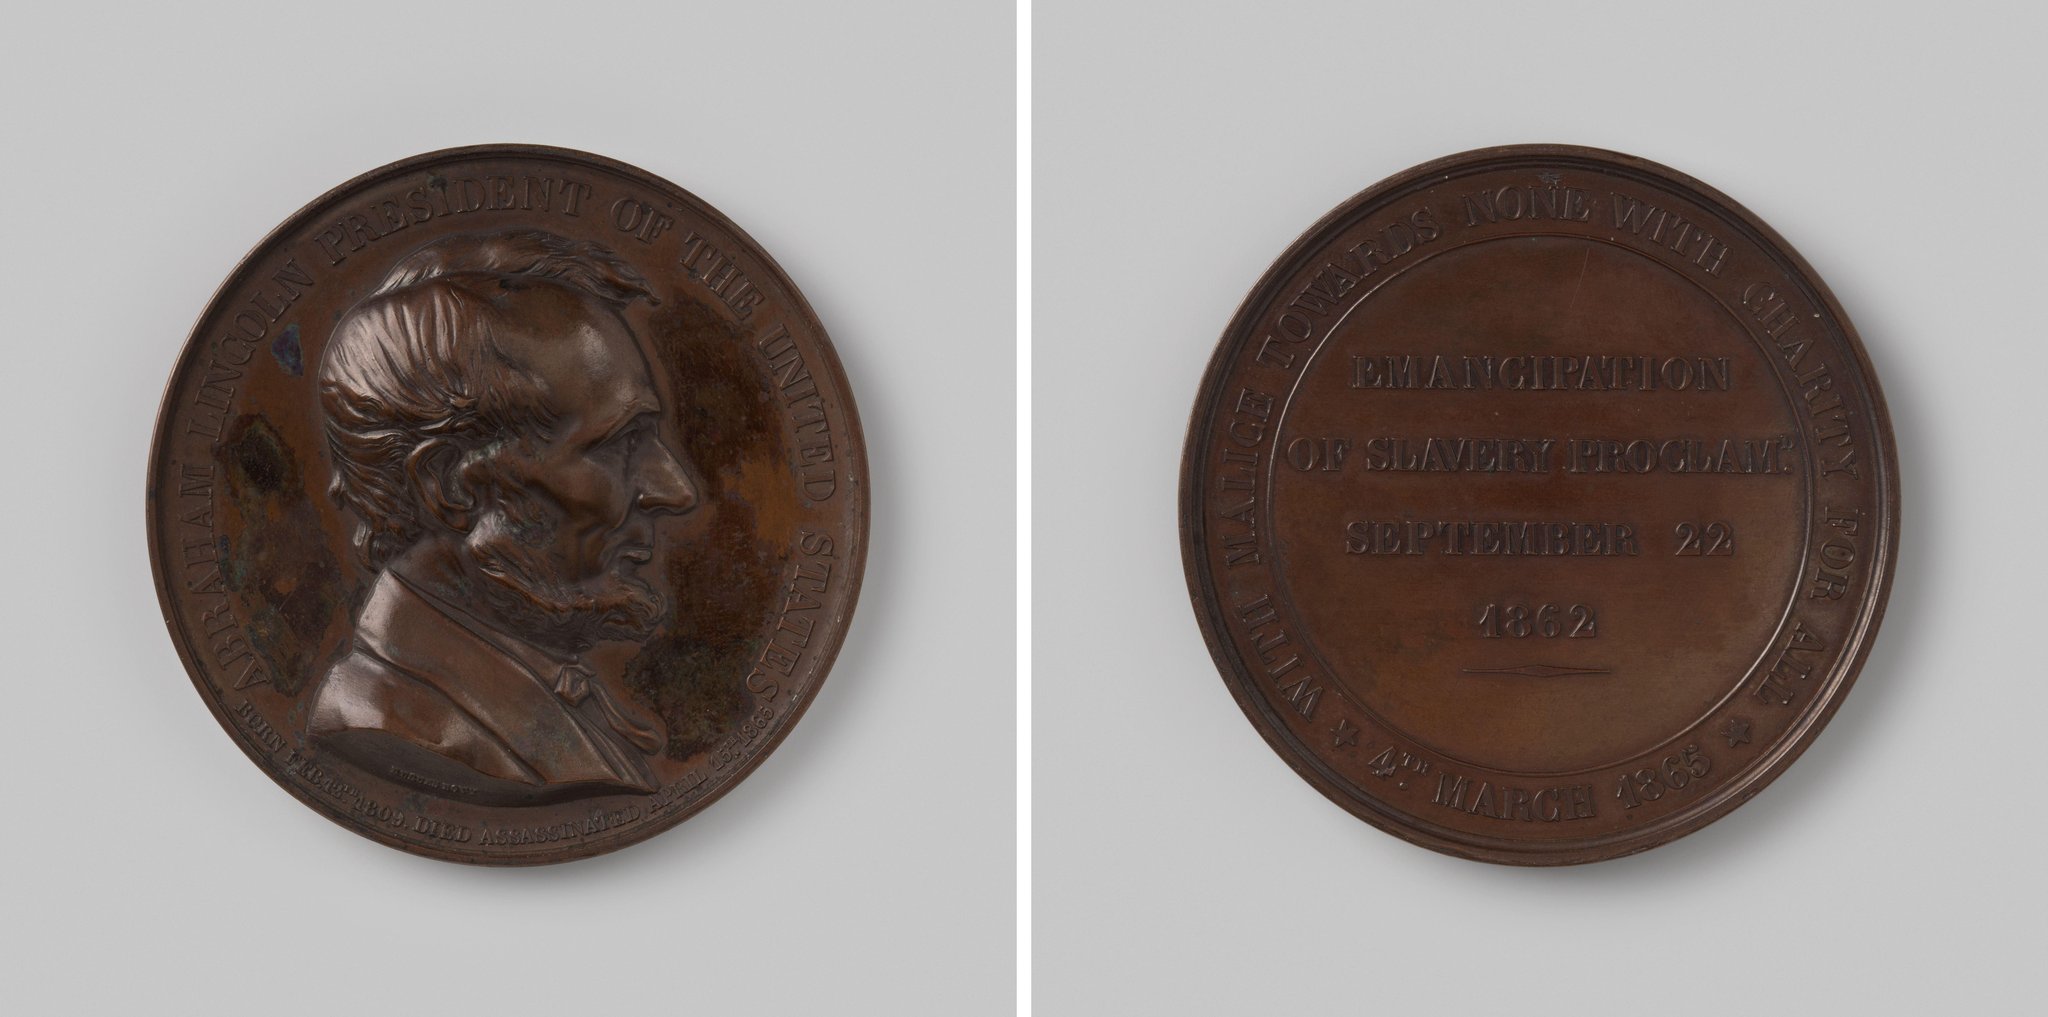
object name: history medal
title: Abraham Lincoln en de afschaffing van de slavernij in Amerika 1862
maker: hugues bovy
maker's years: 1841-1903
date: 1865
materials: bronze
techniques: striking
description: Bronzen penning, op de voorzijde het borstbeeld van Lincoln naar rechts met omschrift en afsnedetekst, op de keerzijde vier regels tekst met omschrift.